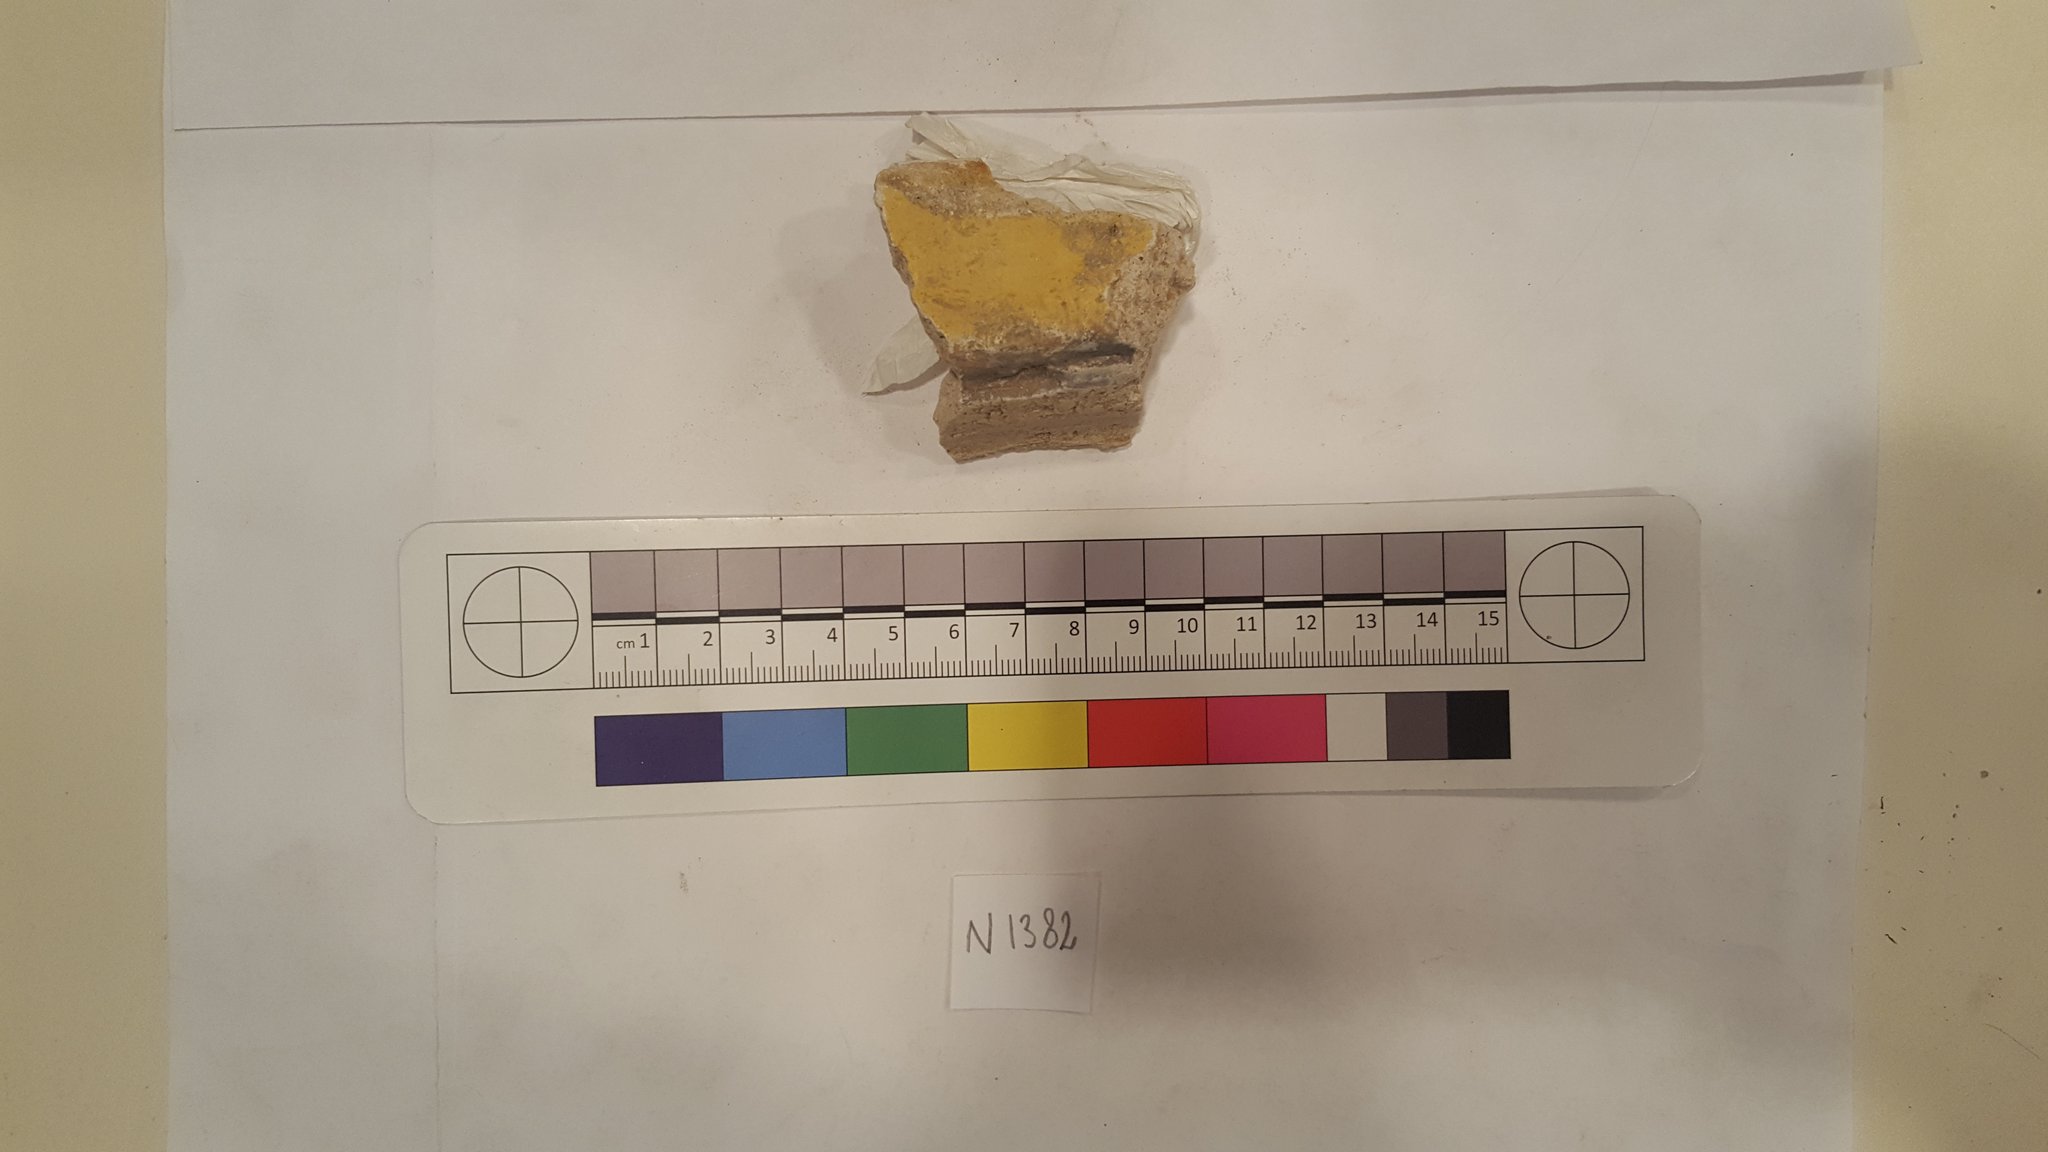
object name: fragment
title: Stucco Fragment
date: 701-1200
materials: plaster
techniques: carving, painting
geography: iran